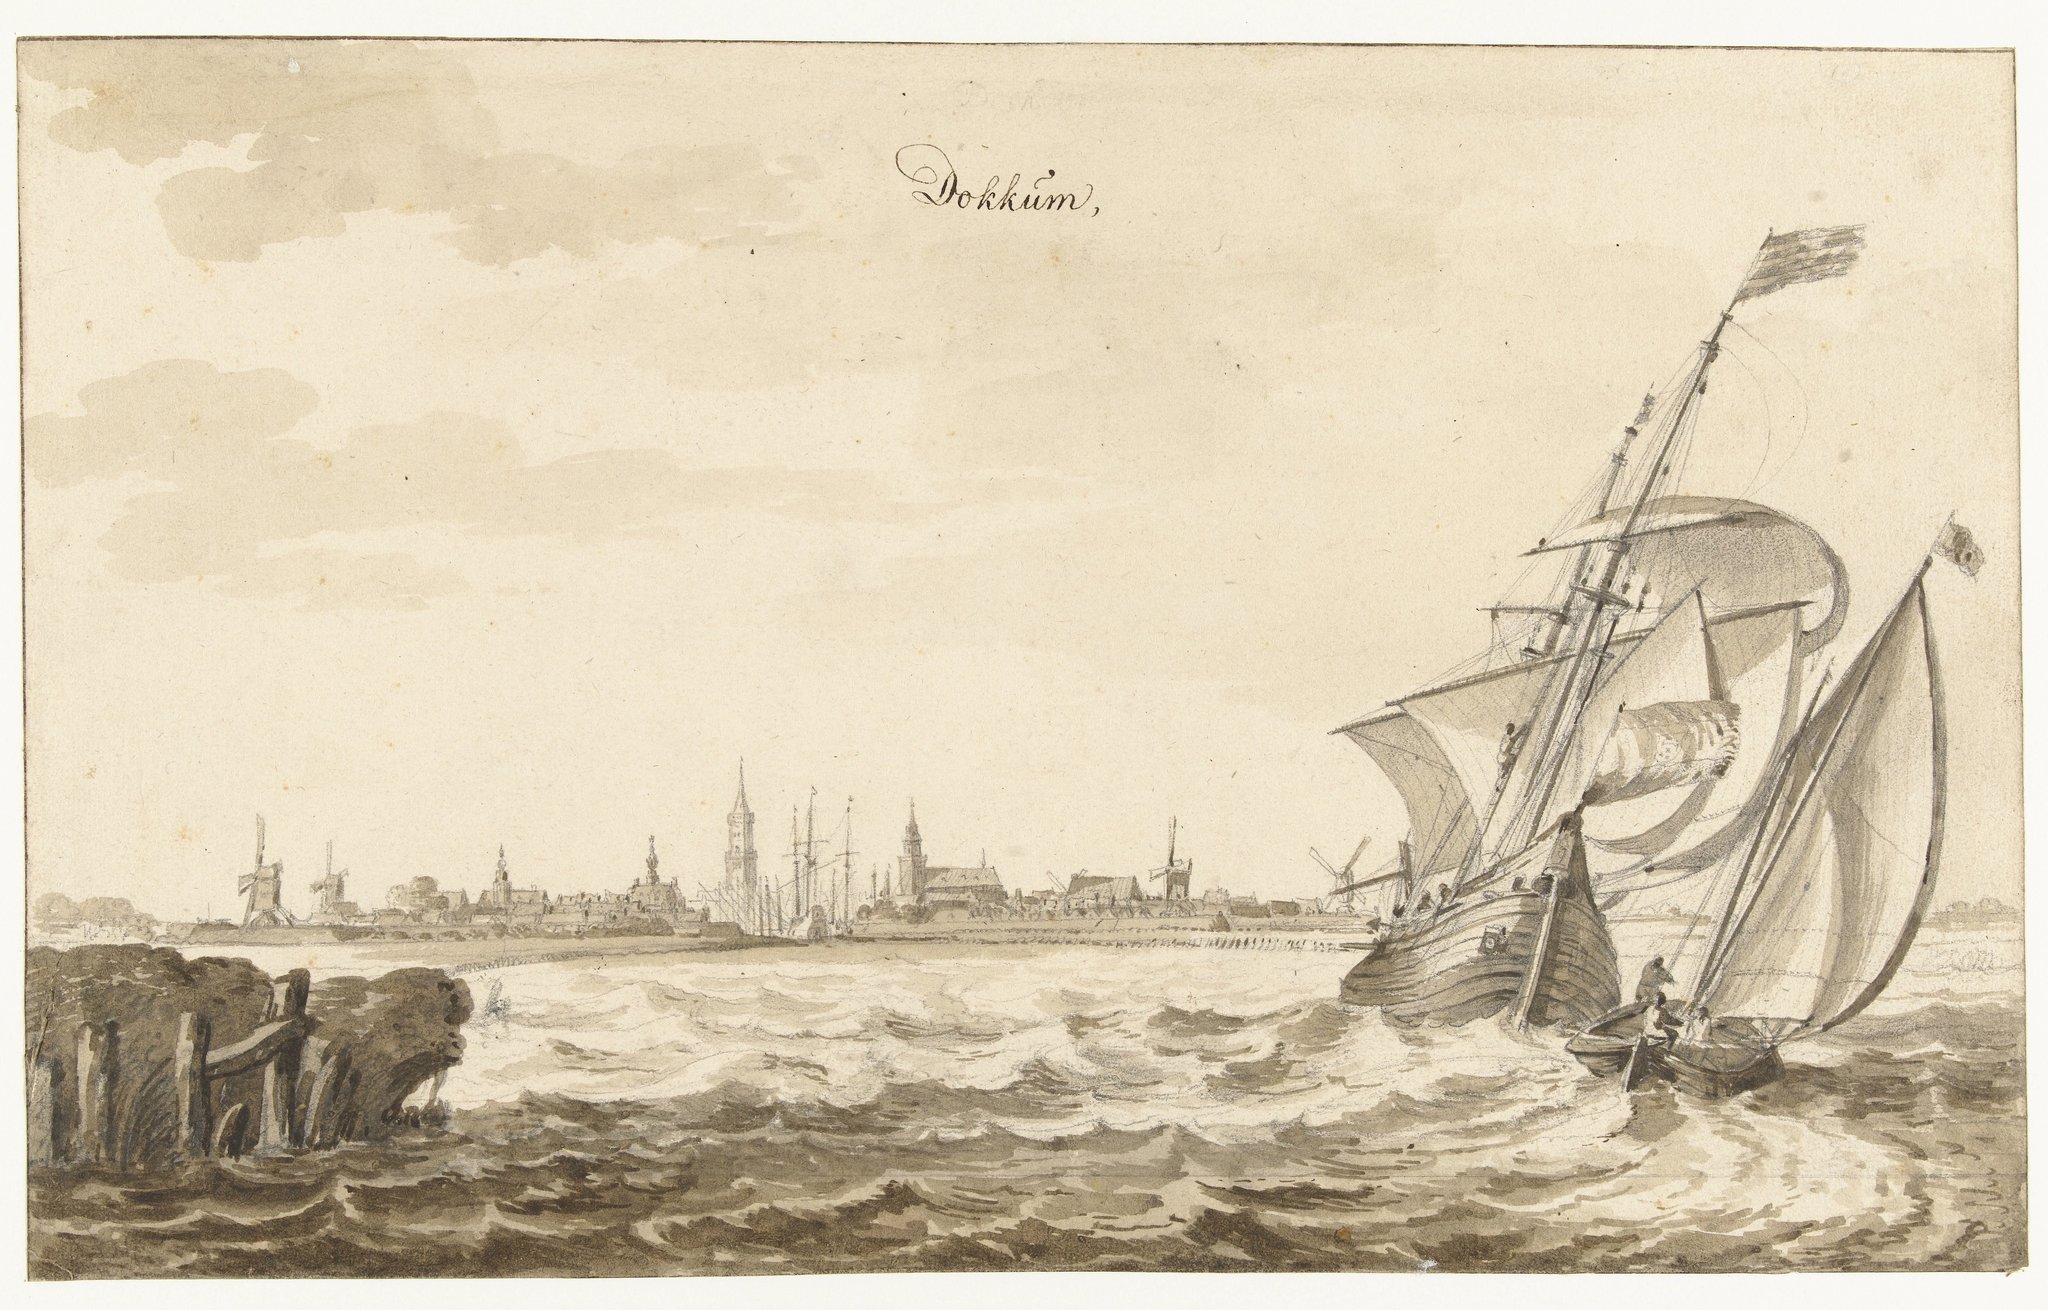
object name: drawing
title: Gezicht over het water op Dokkum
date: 1624-1690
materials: chalk, paper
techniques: brush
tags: sailing-ship, sailing-boat, prospect of city, town panorama, silhouette of city